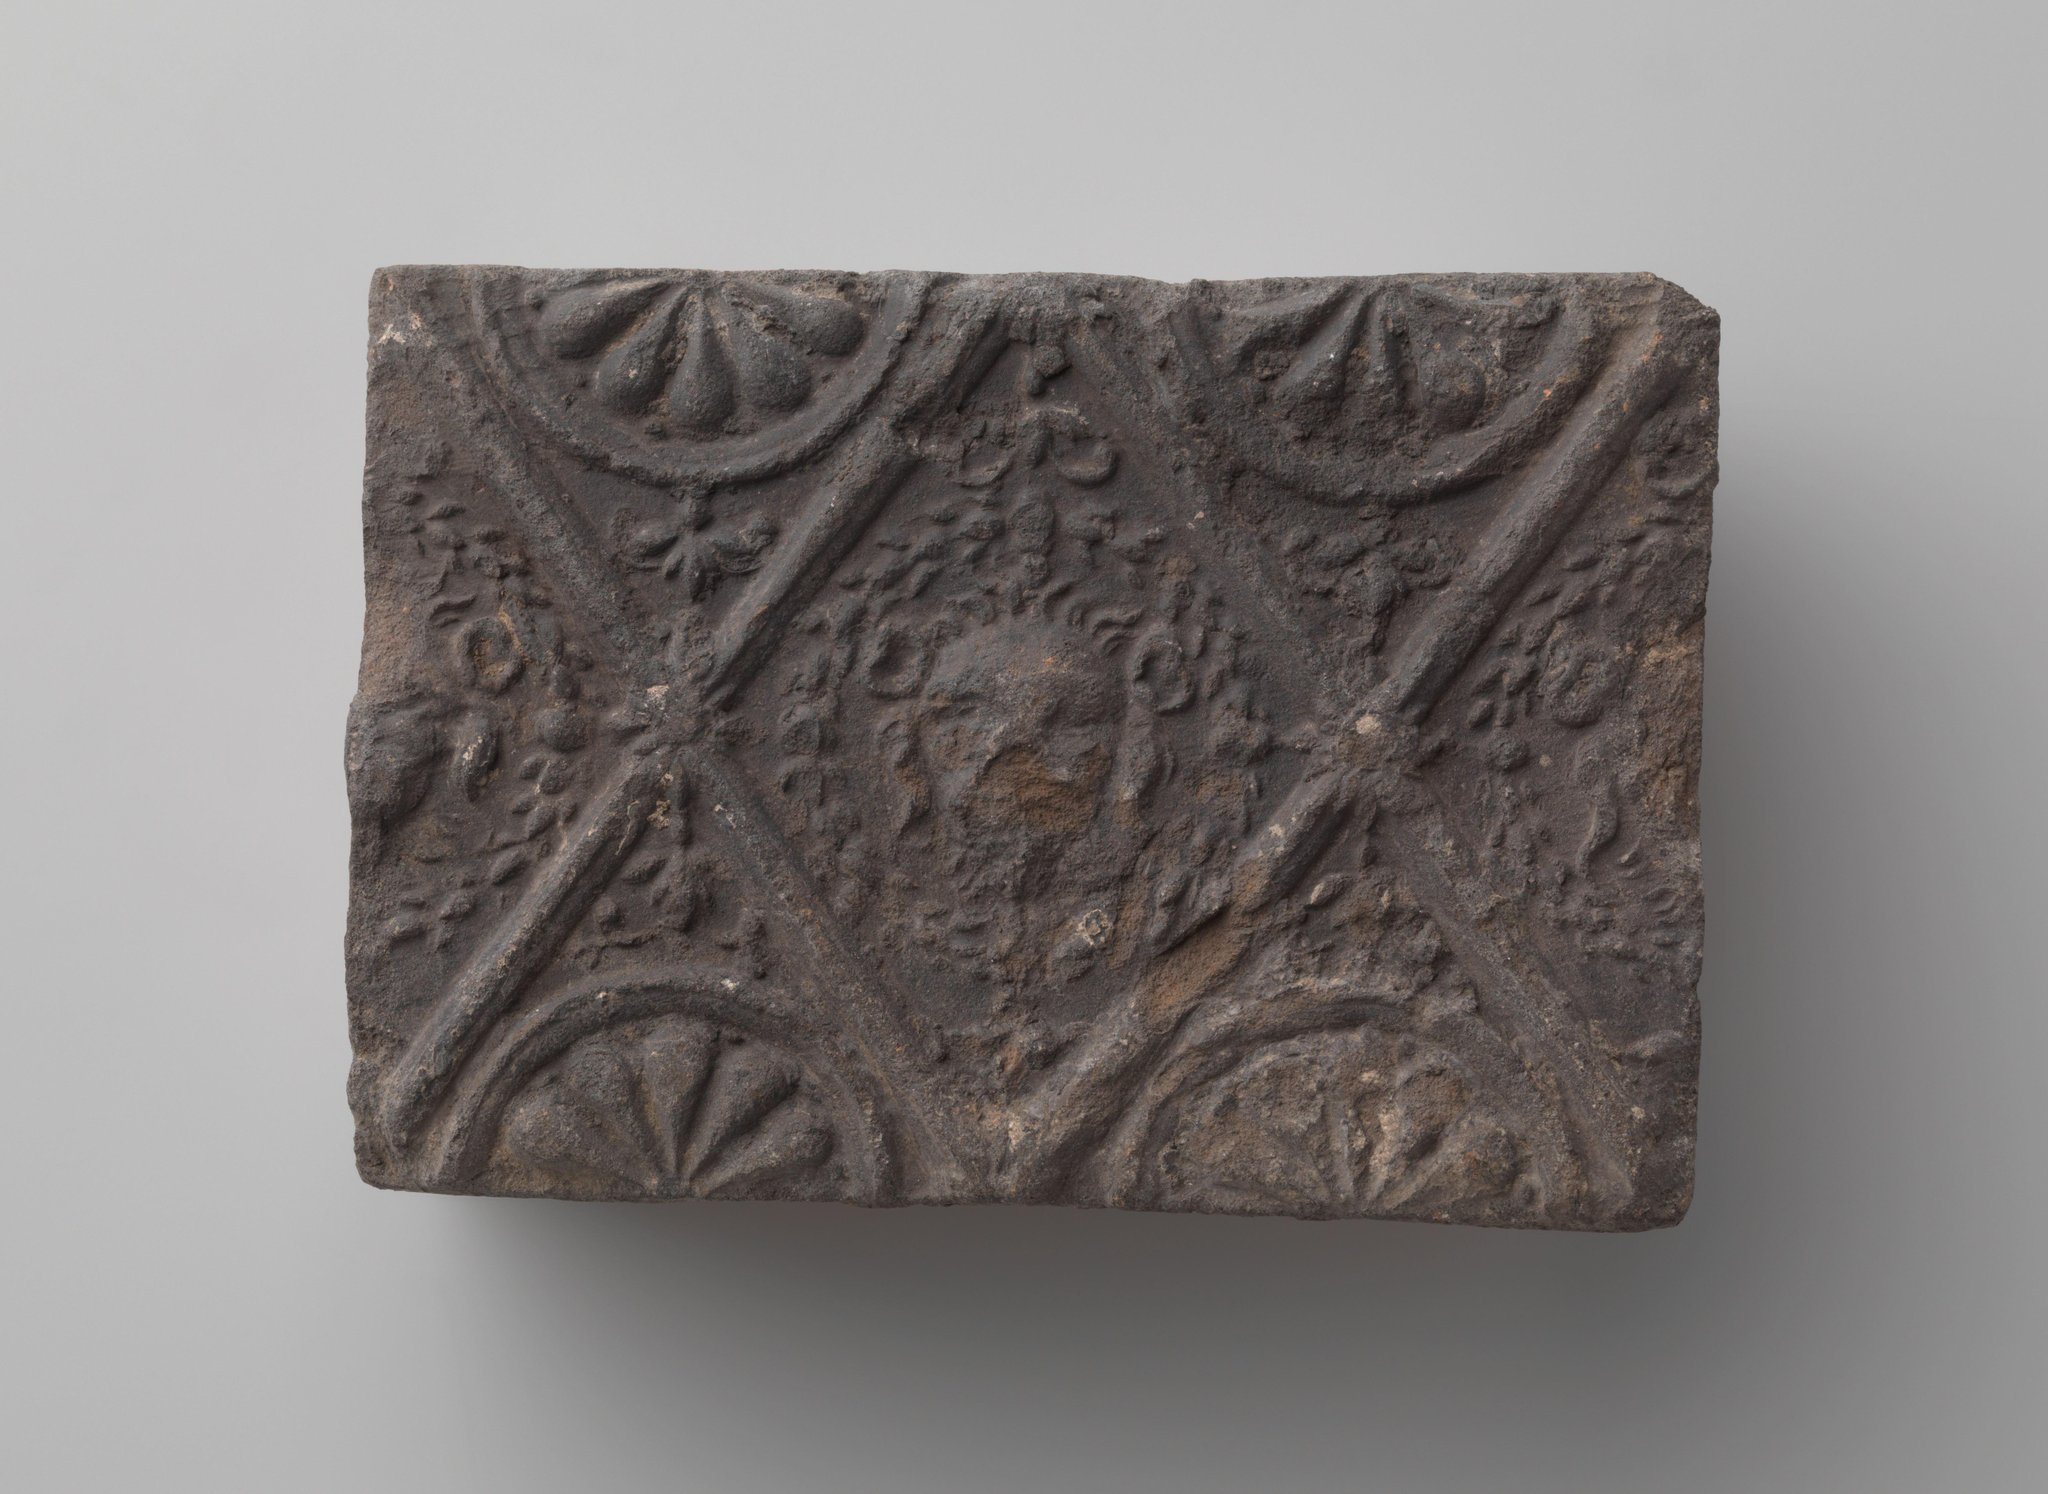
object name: hearthstone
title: Haardsteen met leeuwenkop in geprofileerde ruit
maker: Anonymous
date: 1575-1625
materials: earthenware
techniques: printing, firing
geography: southern netherlands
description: Haardsteen met voorstelling van leeuwenkop in lauwerkrans, geplaatst in geprofileerde ruit, welk motief zich in de halve ruiten aan de zijkanten herhaald. De hale ruiten aan de boven- en onderkant zijn opgevuld met halve medaillons met stermotief.